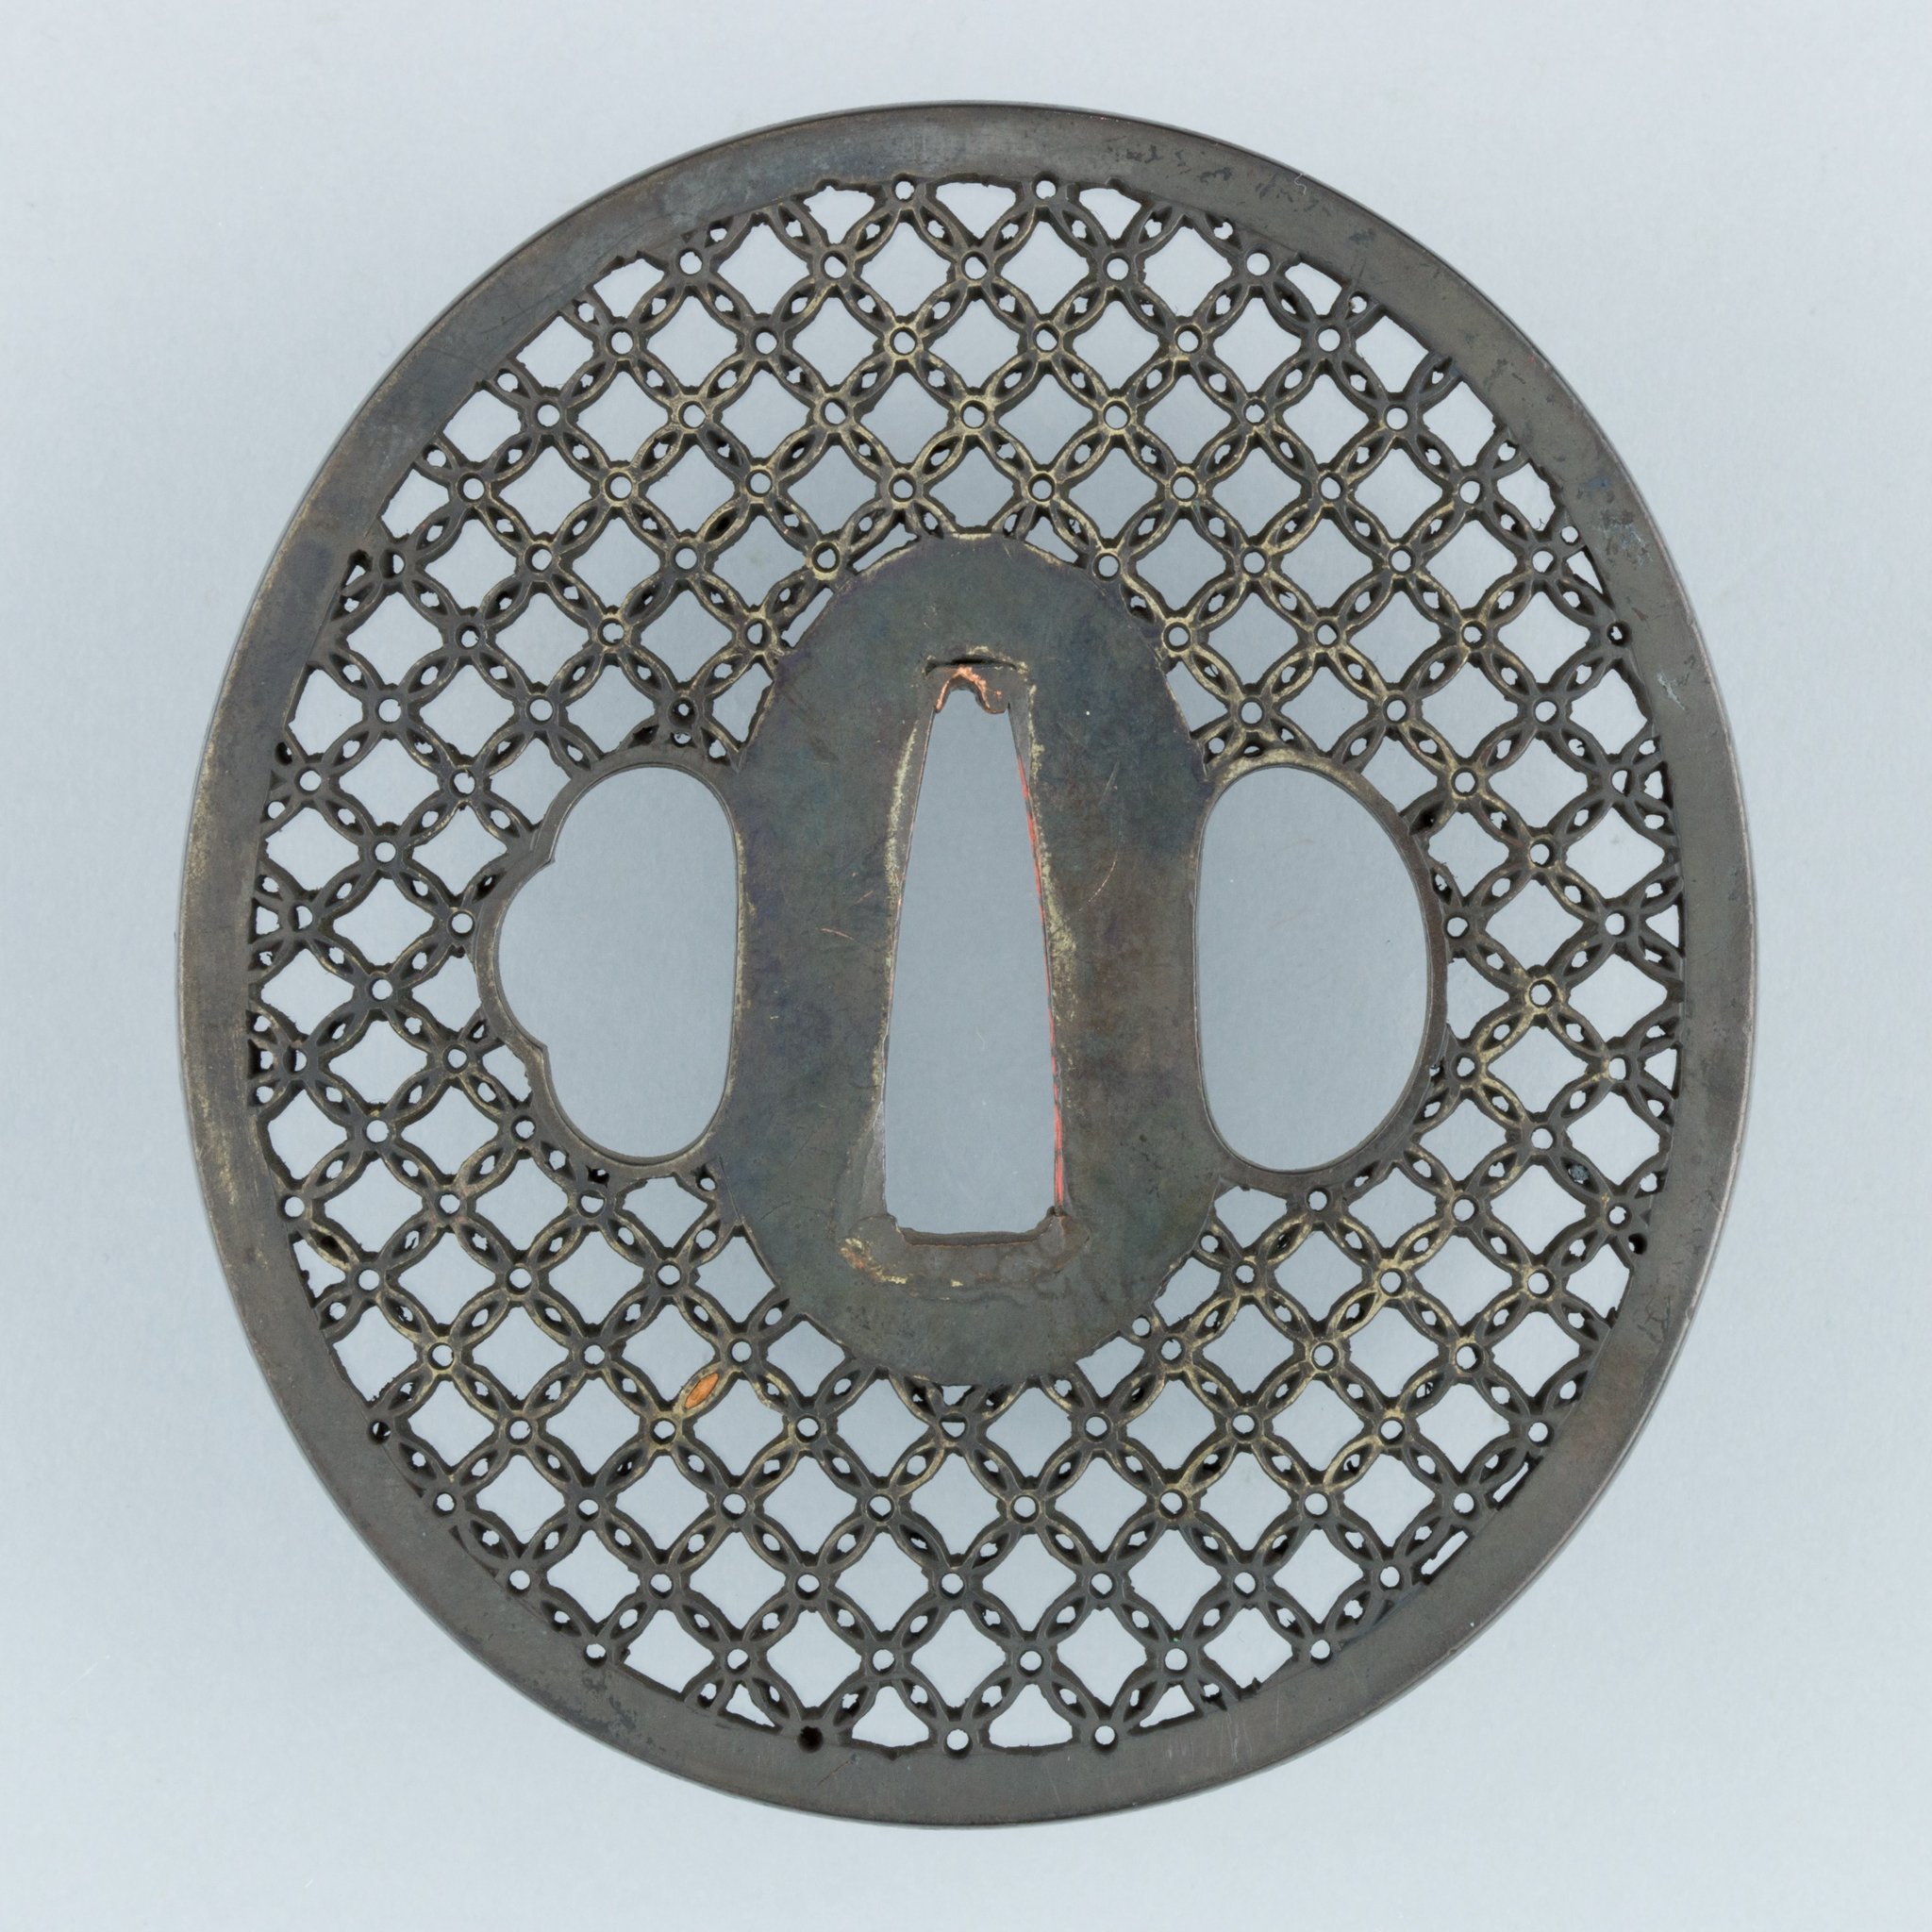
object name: sword guard tsuba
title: Sword Guard (Tsuba)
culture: japanese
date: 1615-1868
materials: copper, silver alloy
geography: japan